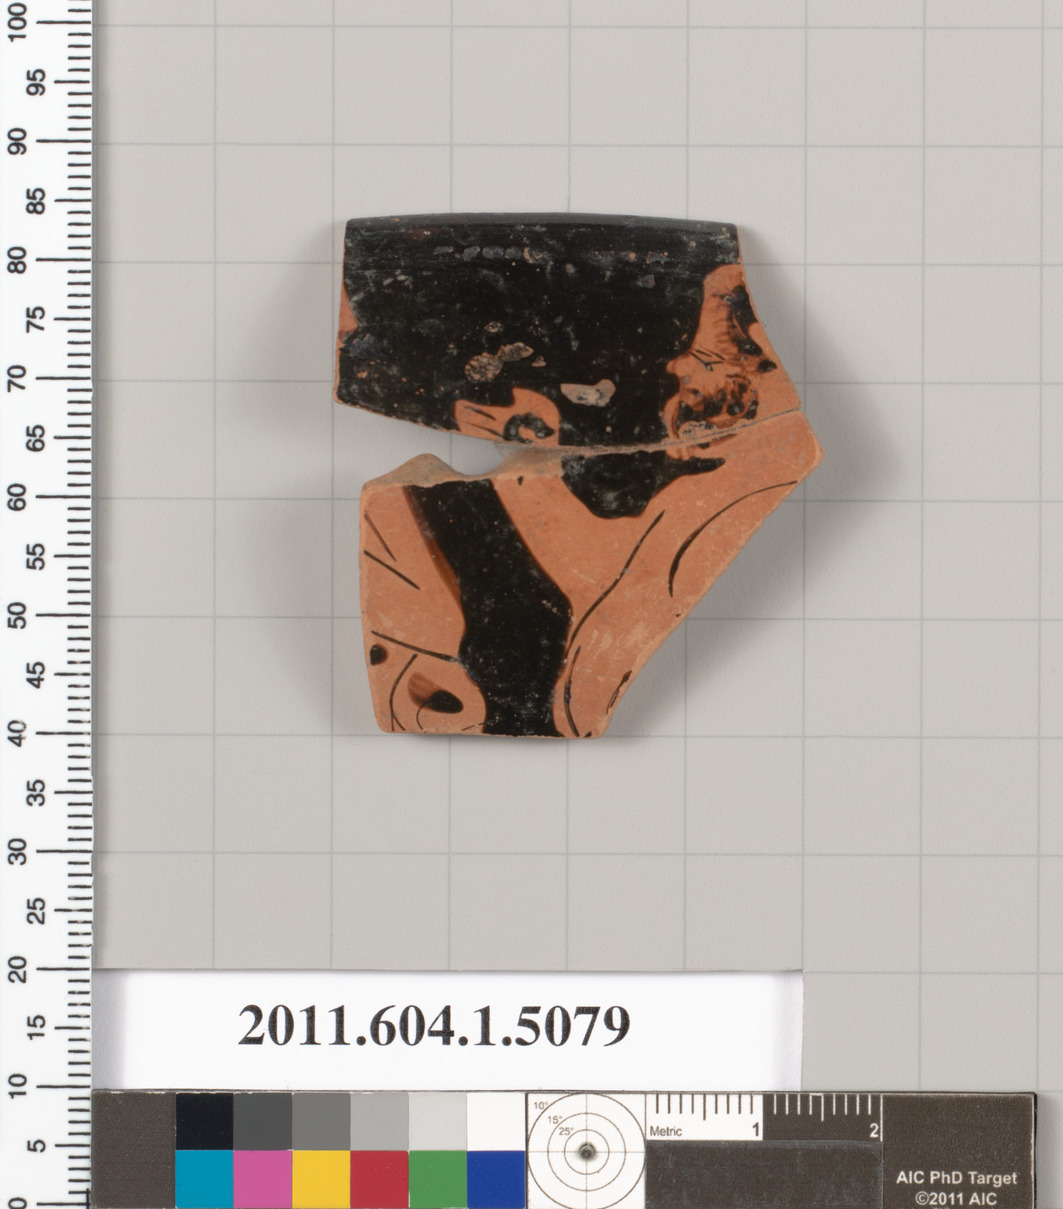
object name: kylix fragment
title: Terracotta rim fragment of a kylix (drinking cup)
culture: greek, attic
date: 450-426 BCE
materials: terracotta